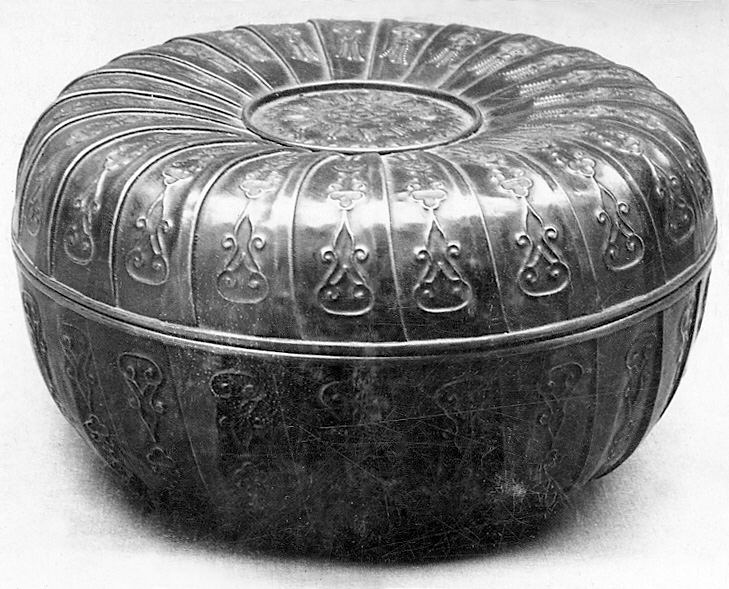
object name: box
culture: japanese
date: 1801-1900